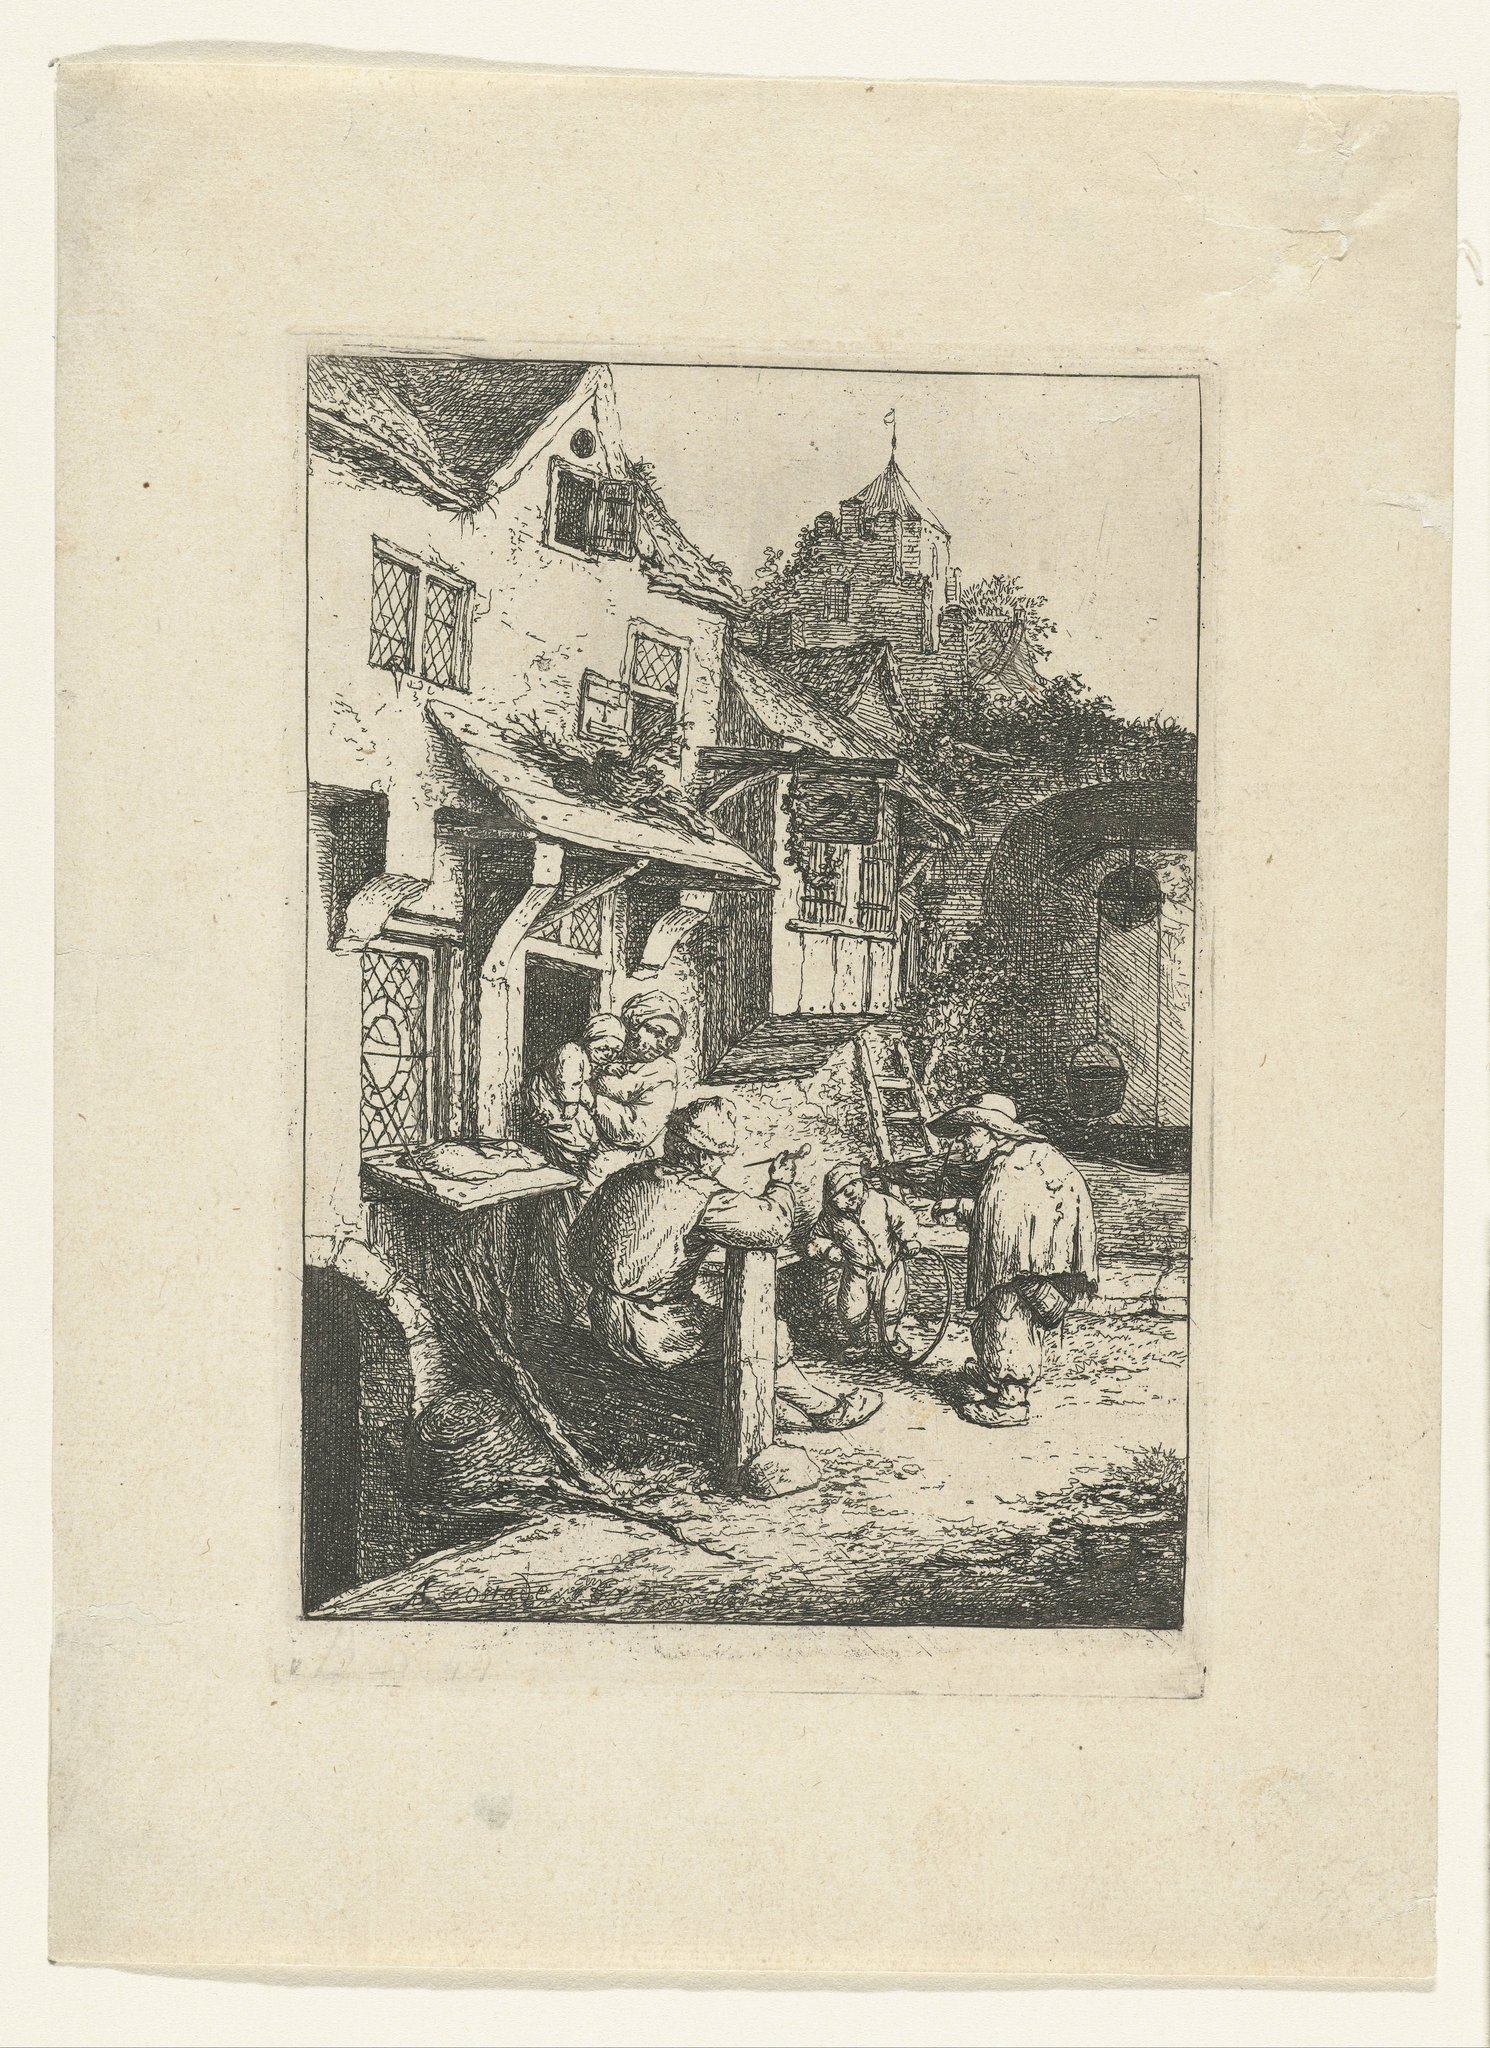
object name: print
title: Gebochelde vioolspeler voor een herberg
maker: adriaen van ostade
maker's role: draughtsman, painter, print maker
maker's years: 1610-1685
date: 1652-1656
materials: paper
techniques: etching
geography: haarlem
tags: one person playing string instrument (bowed), inn, coffee-house, public house, etc.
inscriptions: collector's mark: Lugt 2228, collector's mark: Lugt 2760, collector's mark: ‘moeilijk leesbaar’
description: Een kleine man met een kromme rug speelt viool voor de ingang van een herberg. In de deuropening staat een vrouw met een klein kind op haar arm. Op een hekje rookt een man een pijp en een kleine jongen staat met een hoepel in zijn hand te luisteren.